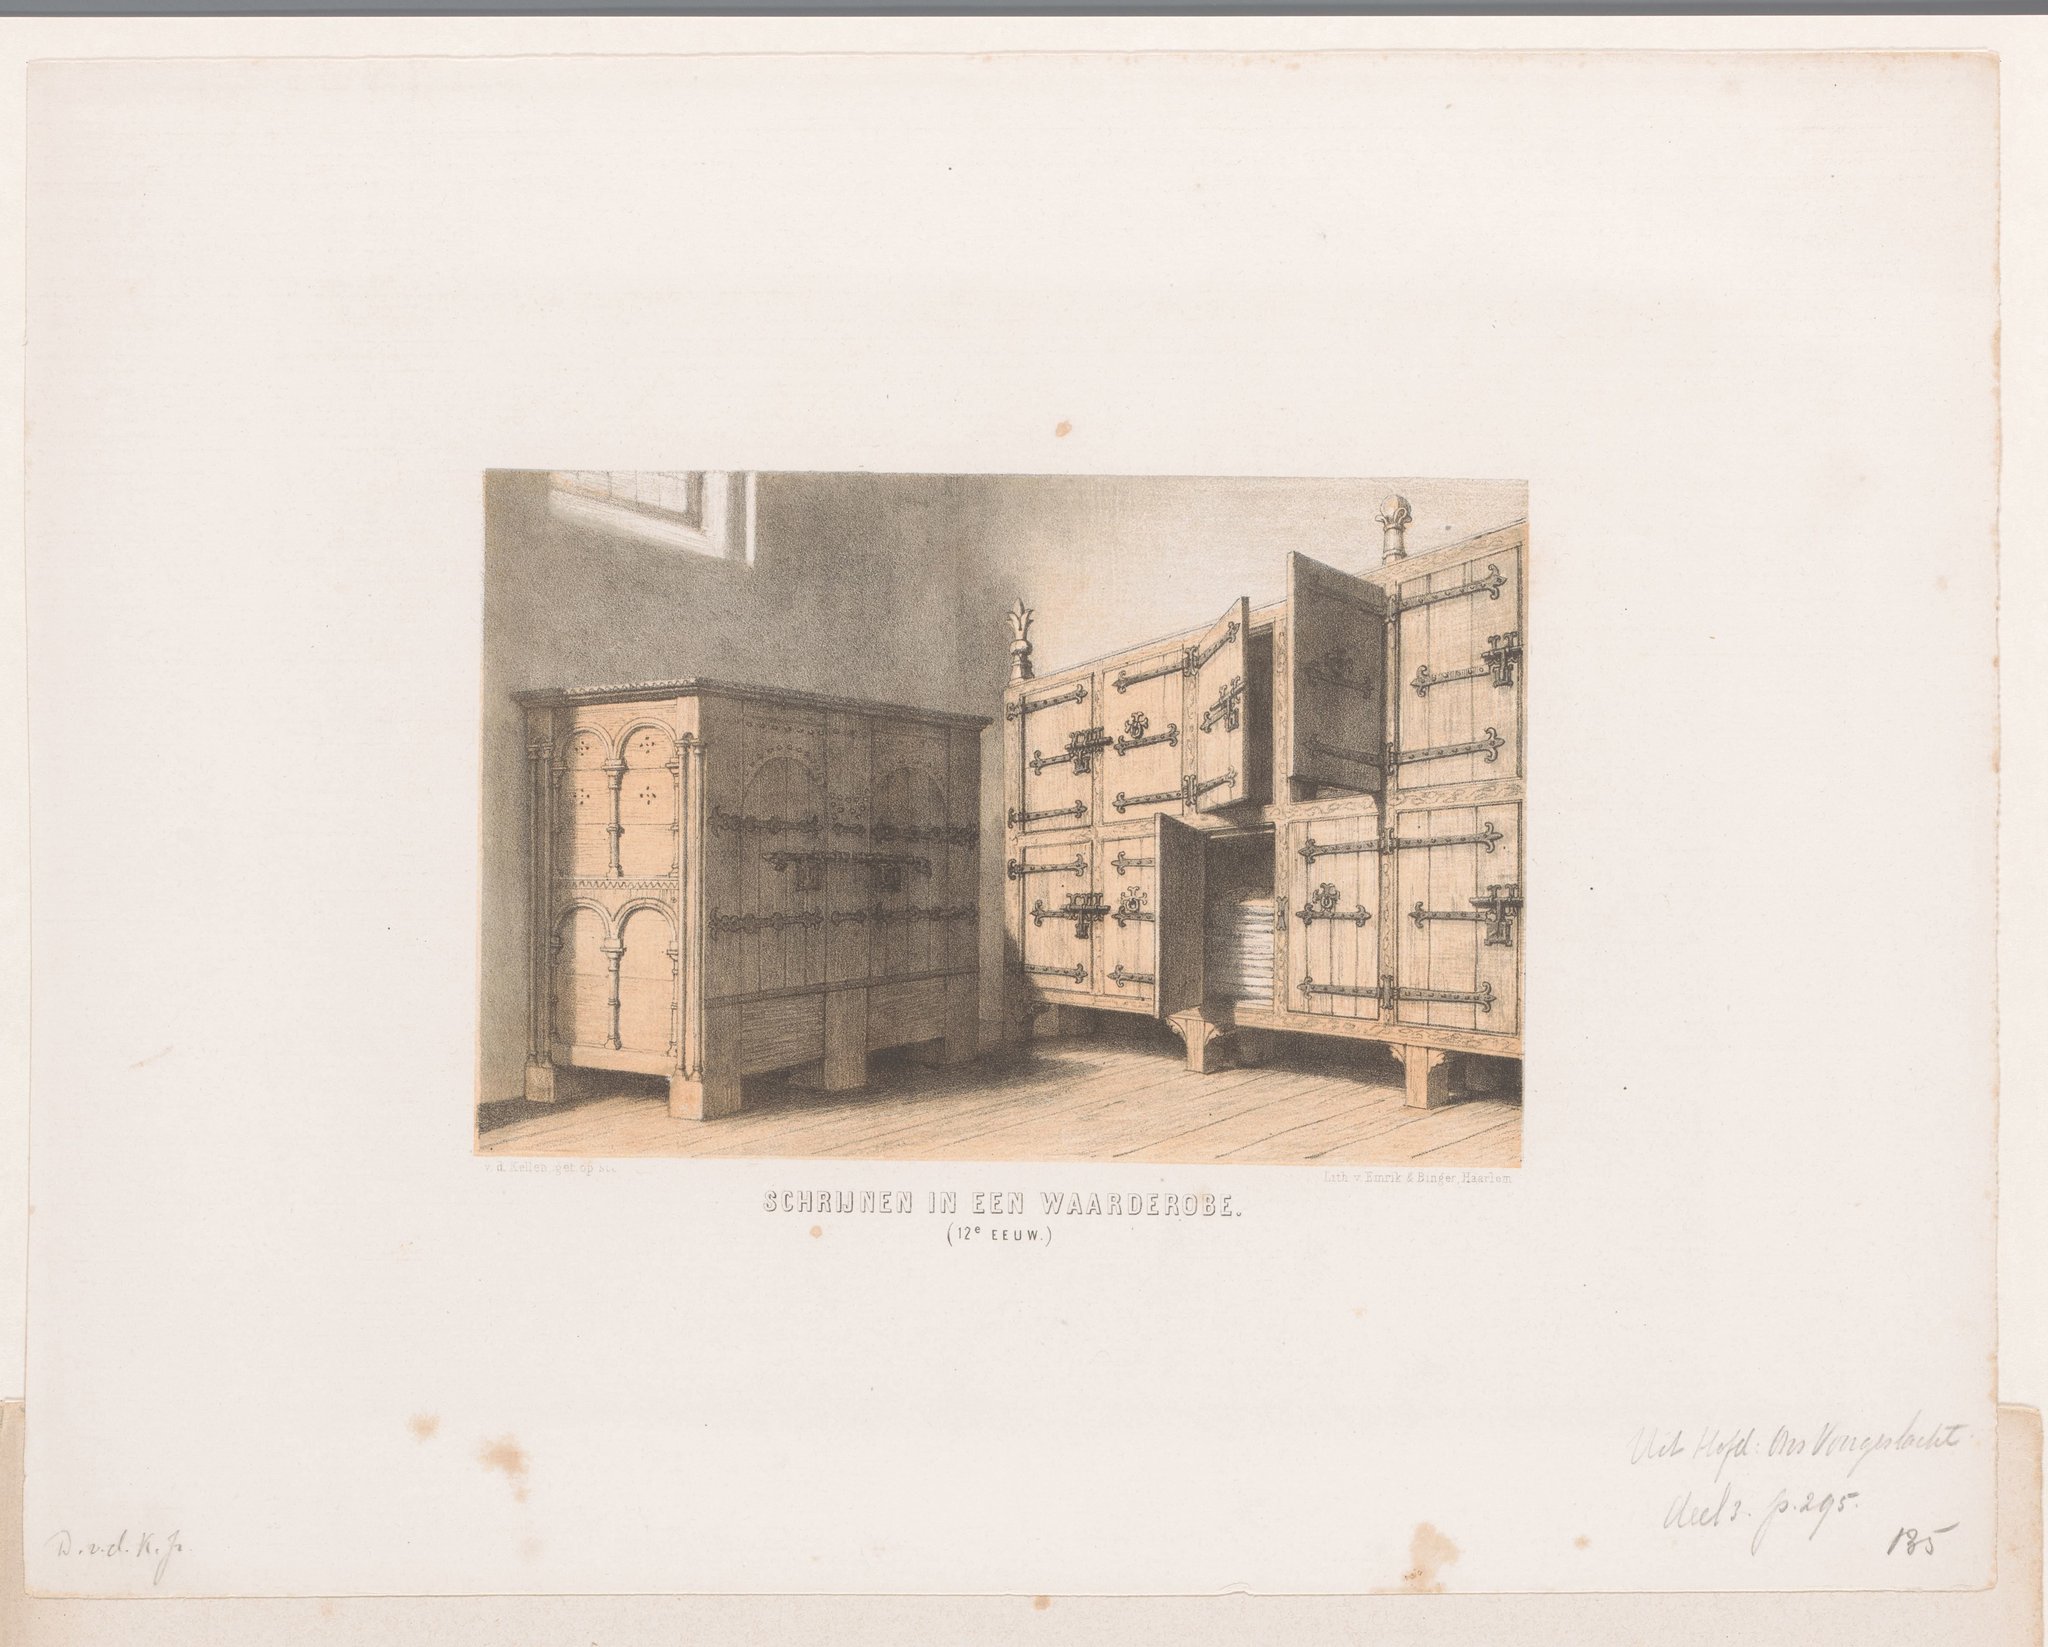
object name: historical object representation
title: Schrijnen in een waarderobe. (12e eeuw)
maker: david van der kellen (1827-1895)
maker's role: draughtsman, print maker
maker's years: 1827-1895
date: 1857-1864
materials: paper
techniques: tone lithography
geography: haarlem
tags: cupboard, netherlands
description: Illustratie voor: W.J. Hofdijk, Ons voorgeslacht in zijn dagelyksch leven geschilderd, Kruseman, Haarlem 1859-1864, dl. 3, p. 295.